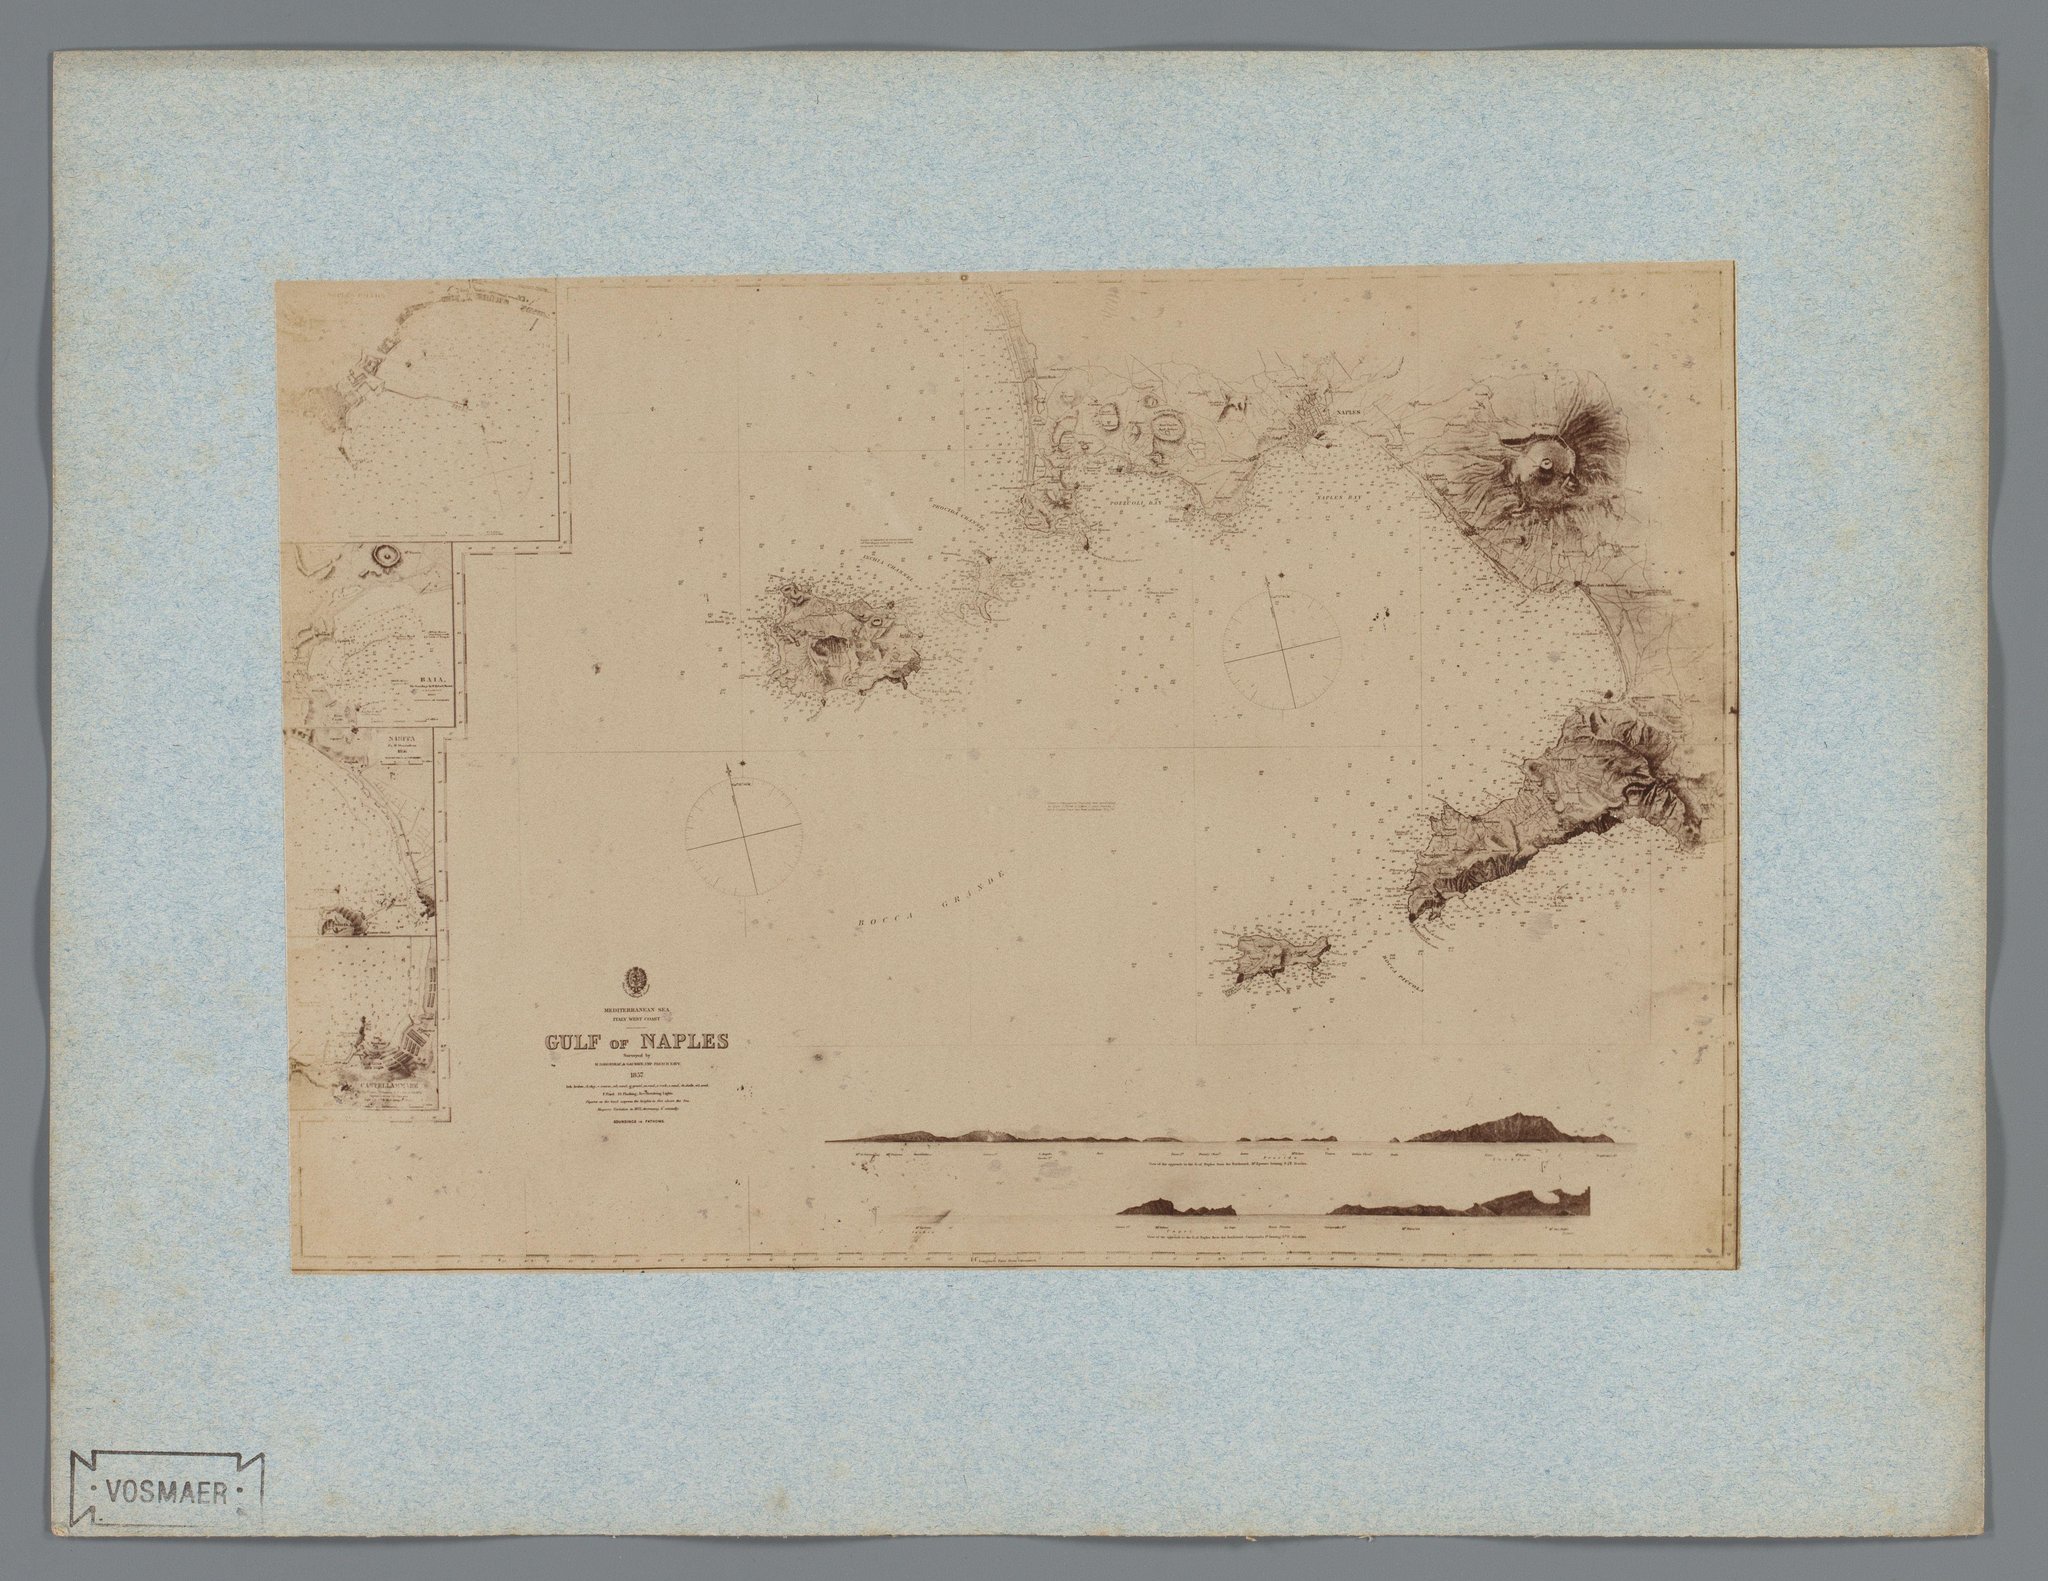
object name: photograph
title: Fotoreproductie van een landkaart van de Golf van Napels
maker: Anonymous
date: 1872-1900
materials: cardboard, paper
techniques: albumen print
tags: marine charts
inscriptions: collector's mark: ‘VOSMAER’